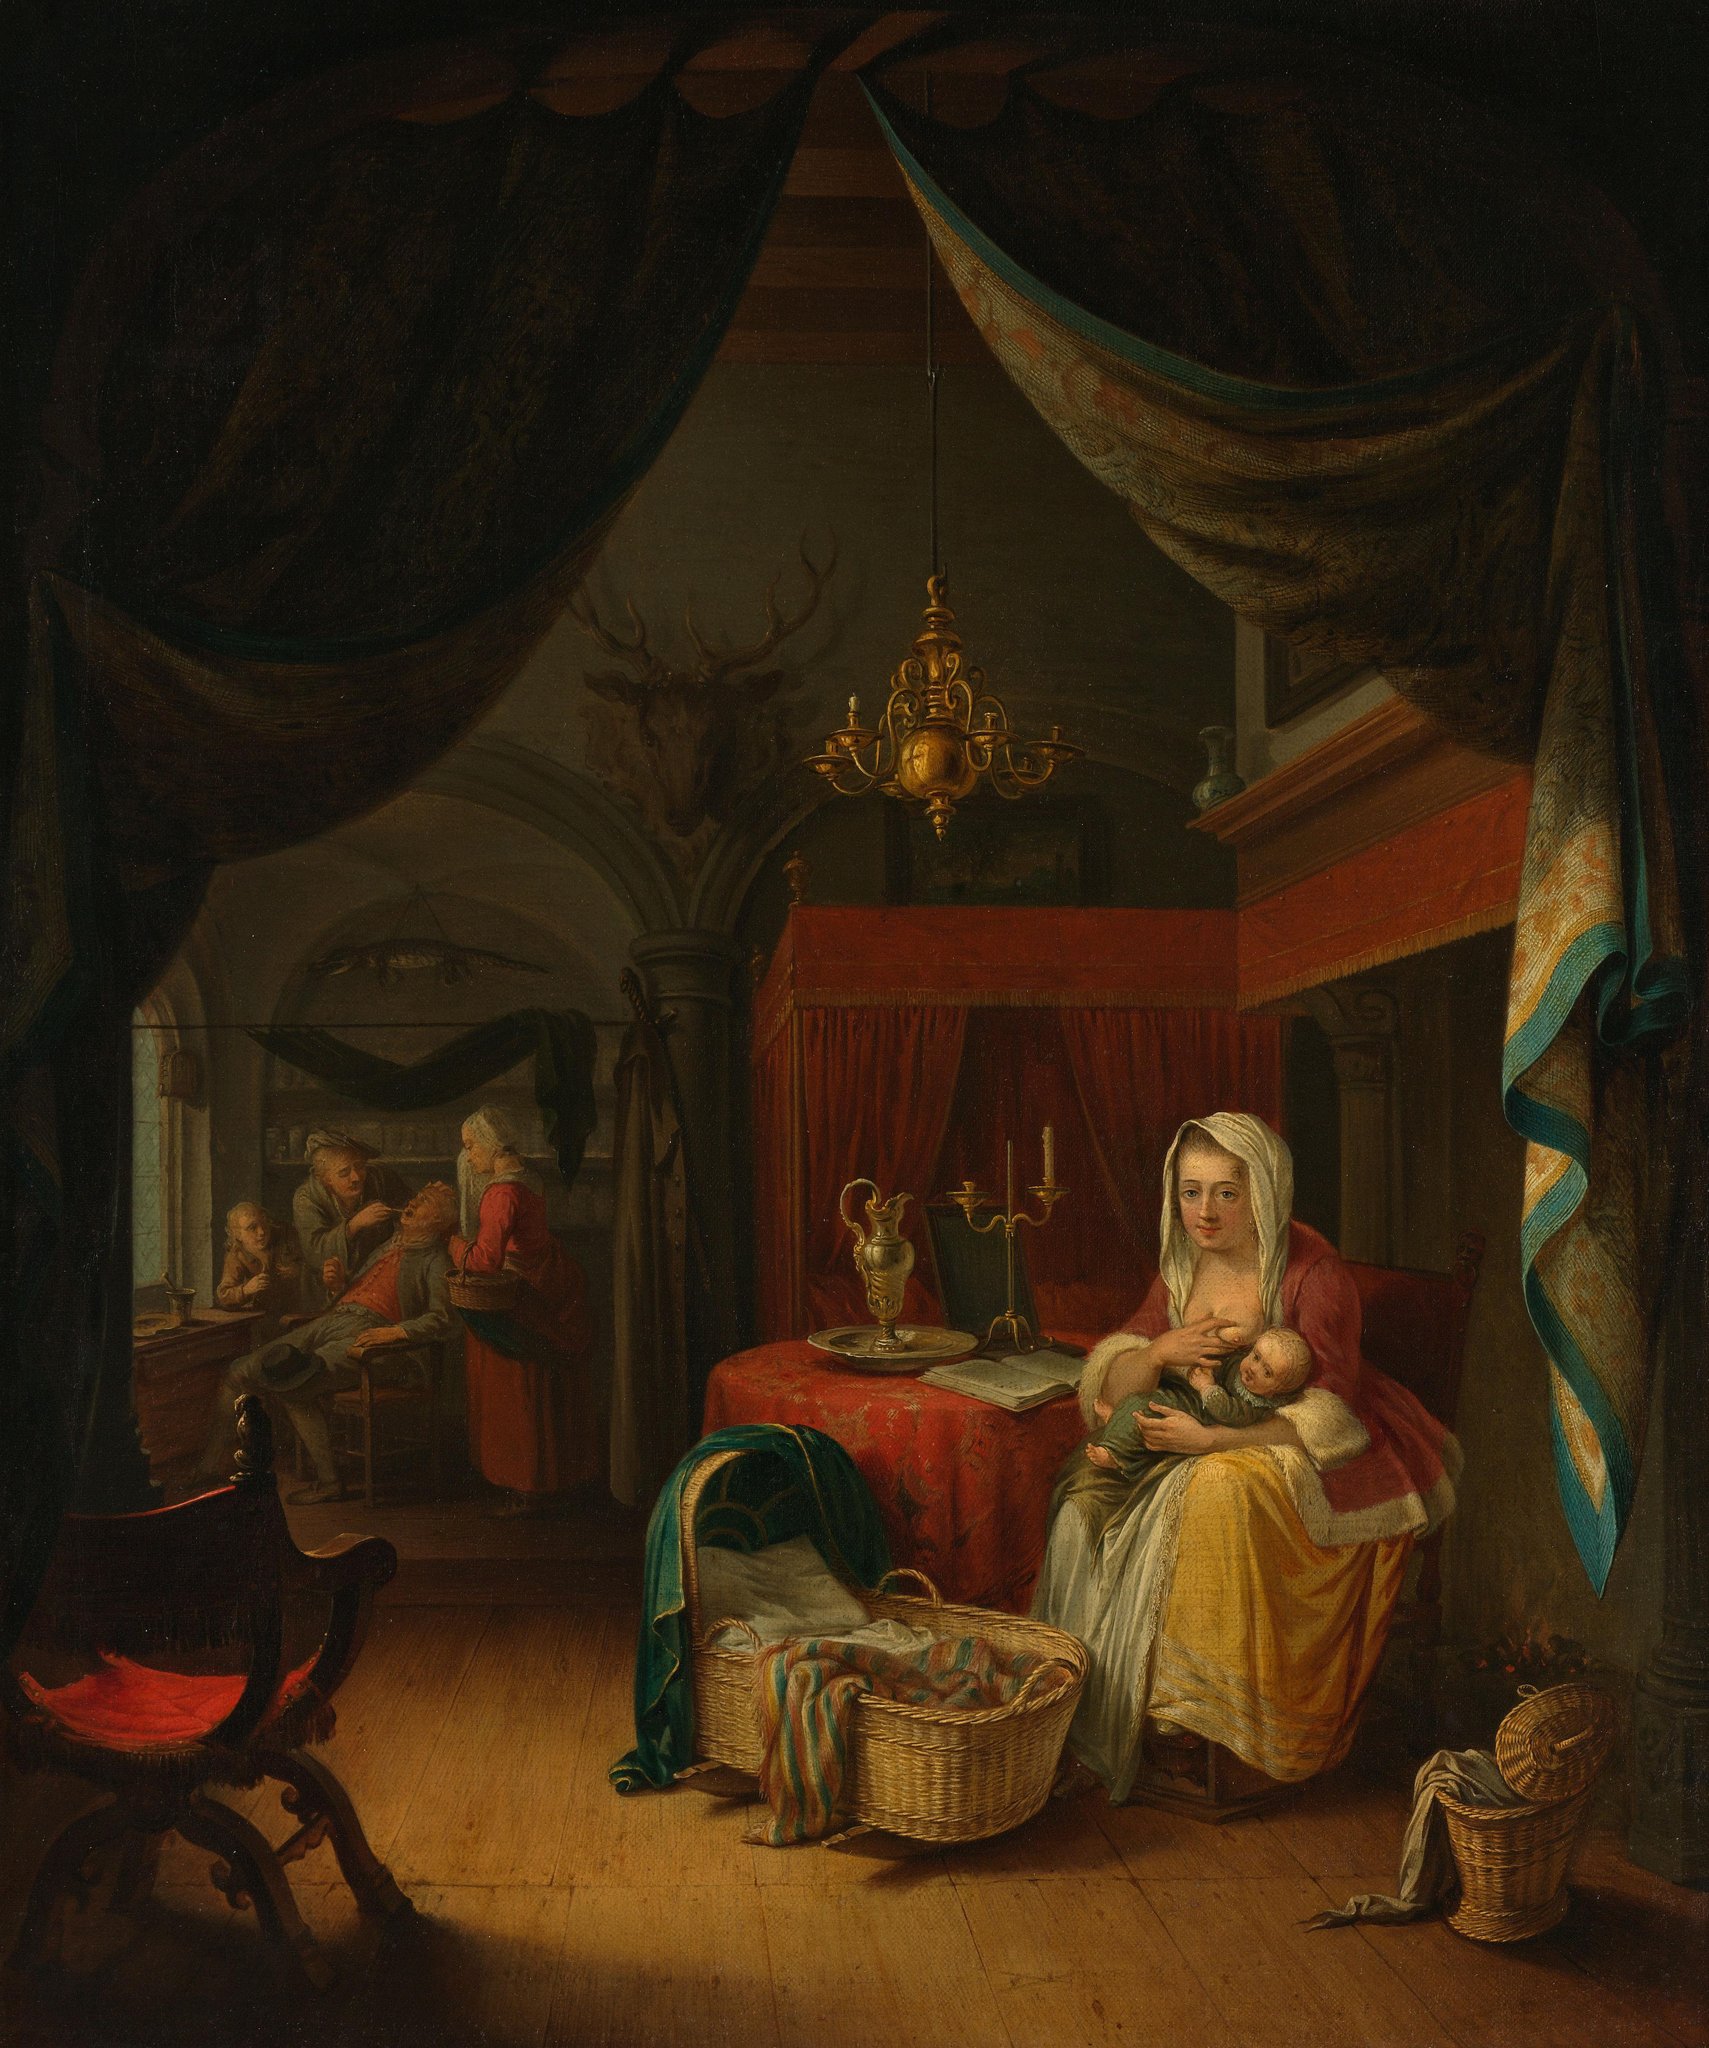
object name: painting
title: Triptych: Allegory of Art Training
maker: willem joseph laquy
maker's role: draughtsman, painter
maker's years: 1738-1798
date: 1770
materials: canvas, oil, paint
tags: nursing, suckling, interior of the house, symbolic representations, allegories and emblems ~ art; 'arte' (ripa), (barber as) dentist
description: Drieluik met een allegorie op het kunstonderwijs. Op het middenpaneel een kraamkamer; een vrouw geeft een kind de borst. Zij is gezeten aan een tafel, de wieg en een mand voor haar op de vloer. Van het plafond hangt een kroonluchter, aan de muur de opgezette kop van een hert. Op de achtergrond een tandarts. De kraamkamer symboliseert de natuur. Het linker zijpaneel toont een avondschool waar bij het licht van kaarsen en een lantaarn schrijven wordt geleerd. De school symboliseert het onderwijs. Op het rechter zijpaneel snijdt een geleerde in zijn werkkamer een pen bij het licht van de kaars. De pennensnijder symboliseert oefening. (voor het linker- en rechter zijpaneel zie SK-A-2320-B/C)